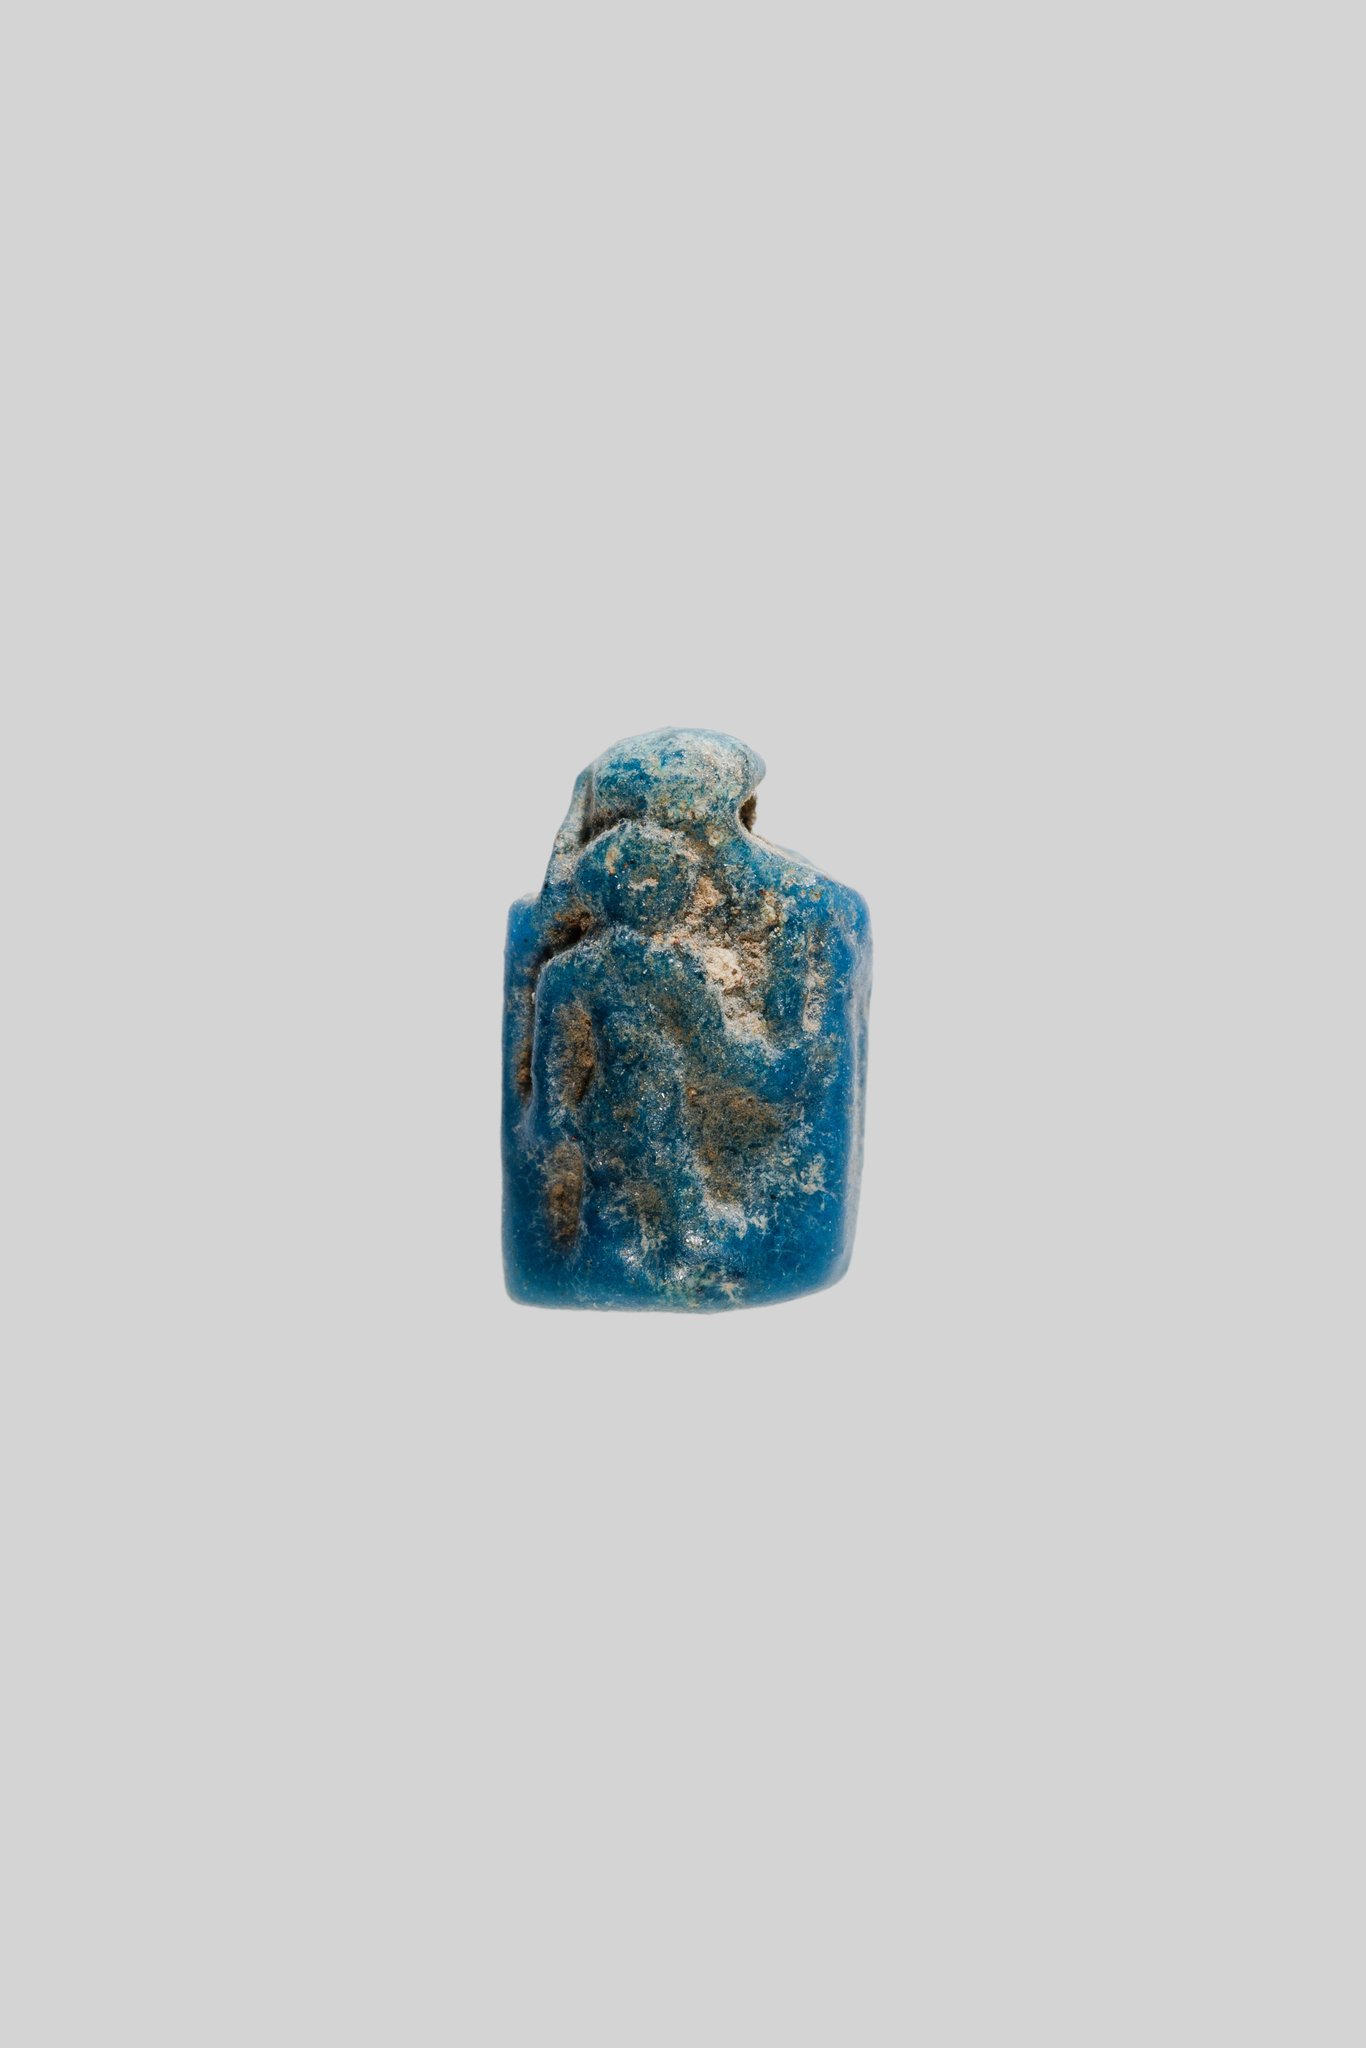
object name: amulet, deity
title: Amulet of a standing deity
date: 1295-1070 BCE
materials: faience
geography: egypt